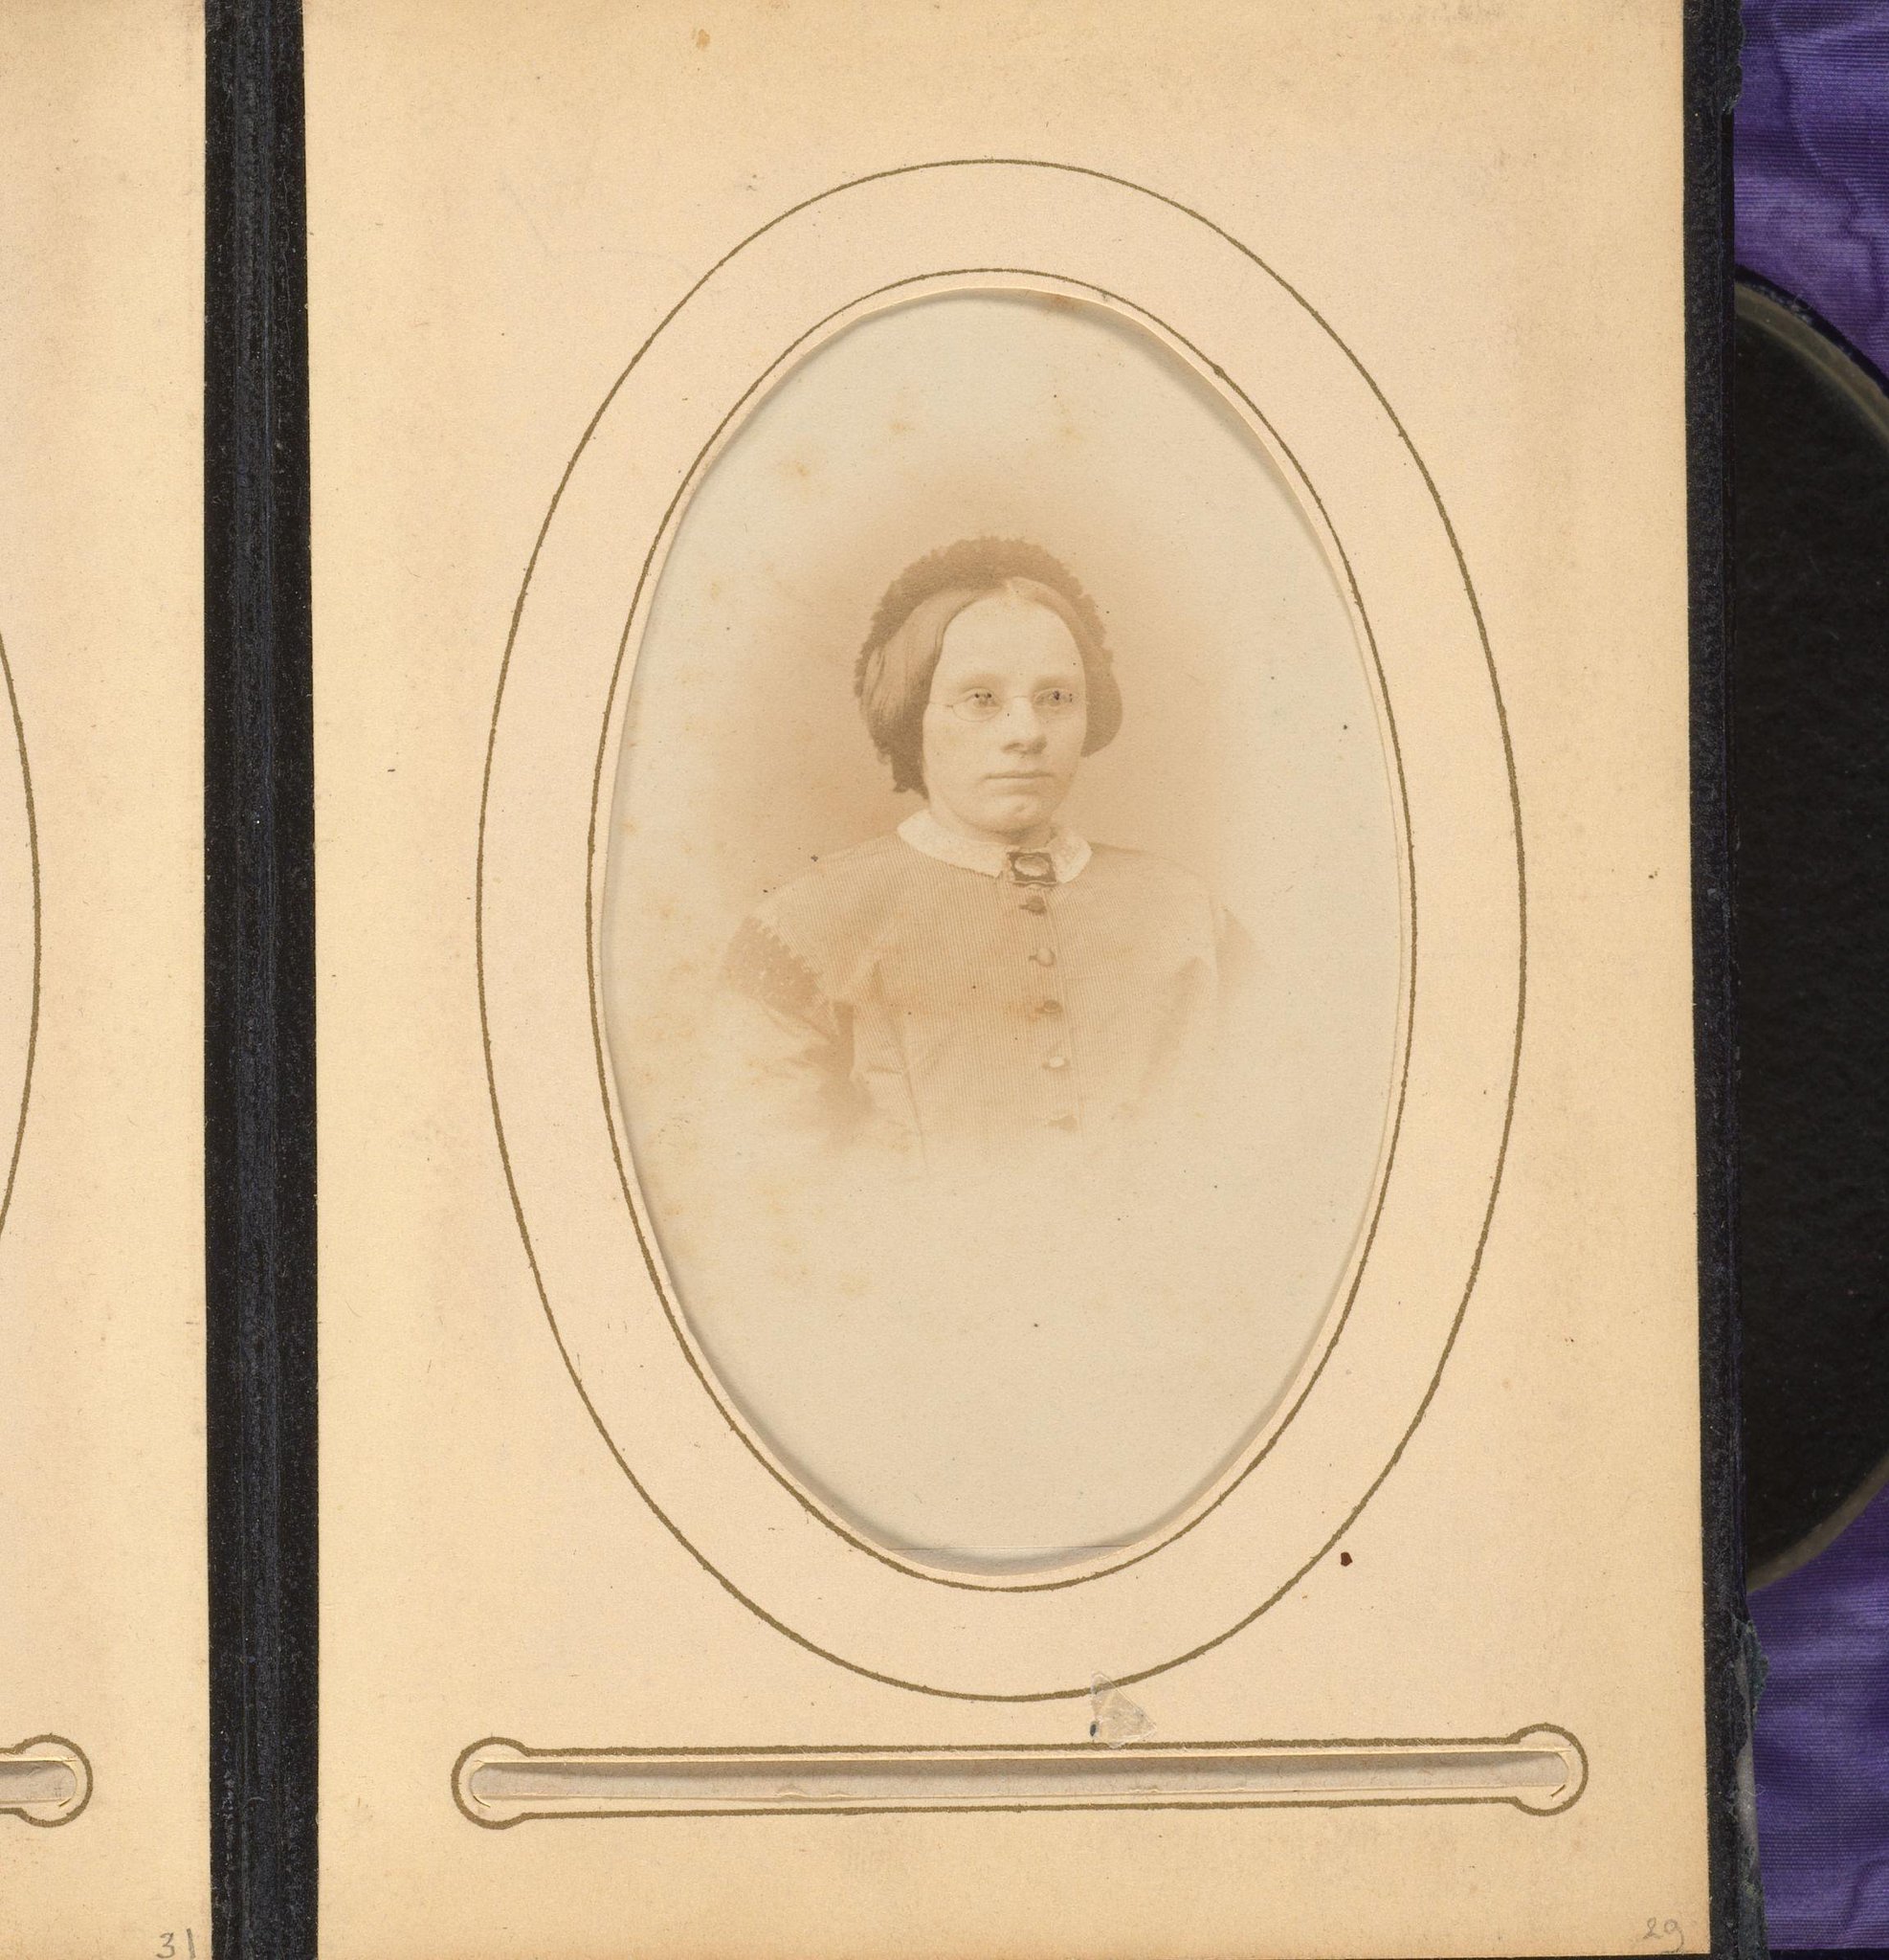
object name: carte de visite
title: Portret van een vrouw met bril en muts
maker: jacobus van gorkom (jr.)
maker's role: print maker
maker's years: 1827-1880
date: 1862-1871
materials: cardboard, photographic support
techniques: albumen print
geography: rotterdam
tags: eyeglasses, spectacles, historical persons - bb - woman, head-gear: cap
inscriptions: inscription: ‘J. van Gorkom Jr./ PHOTOGRAPHE/ ROTTERDAM./ KRUISKADE/ WIJK, 14, 592’